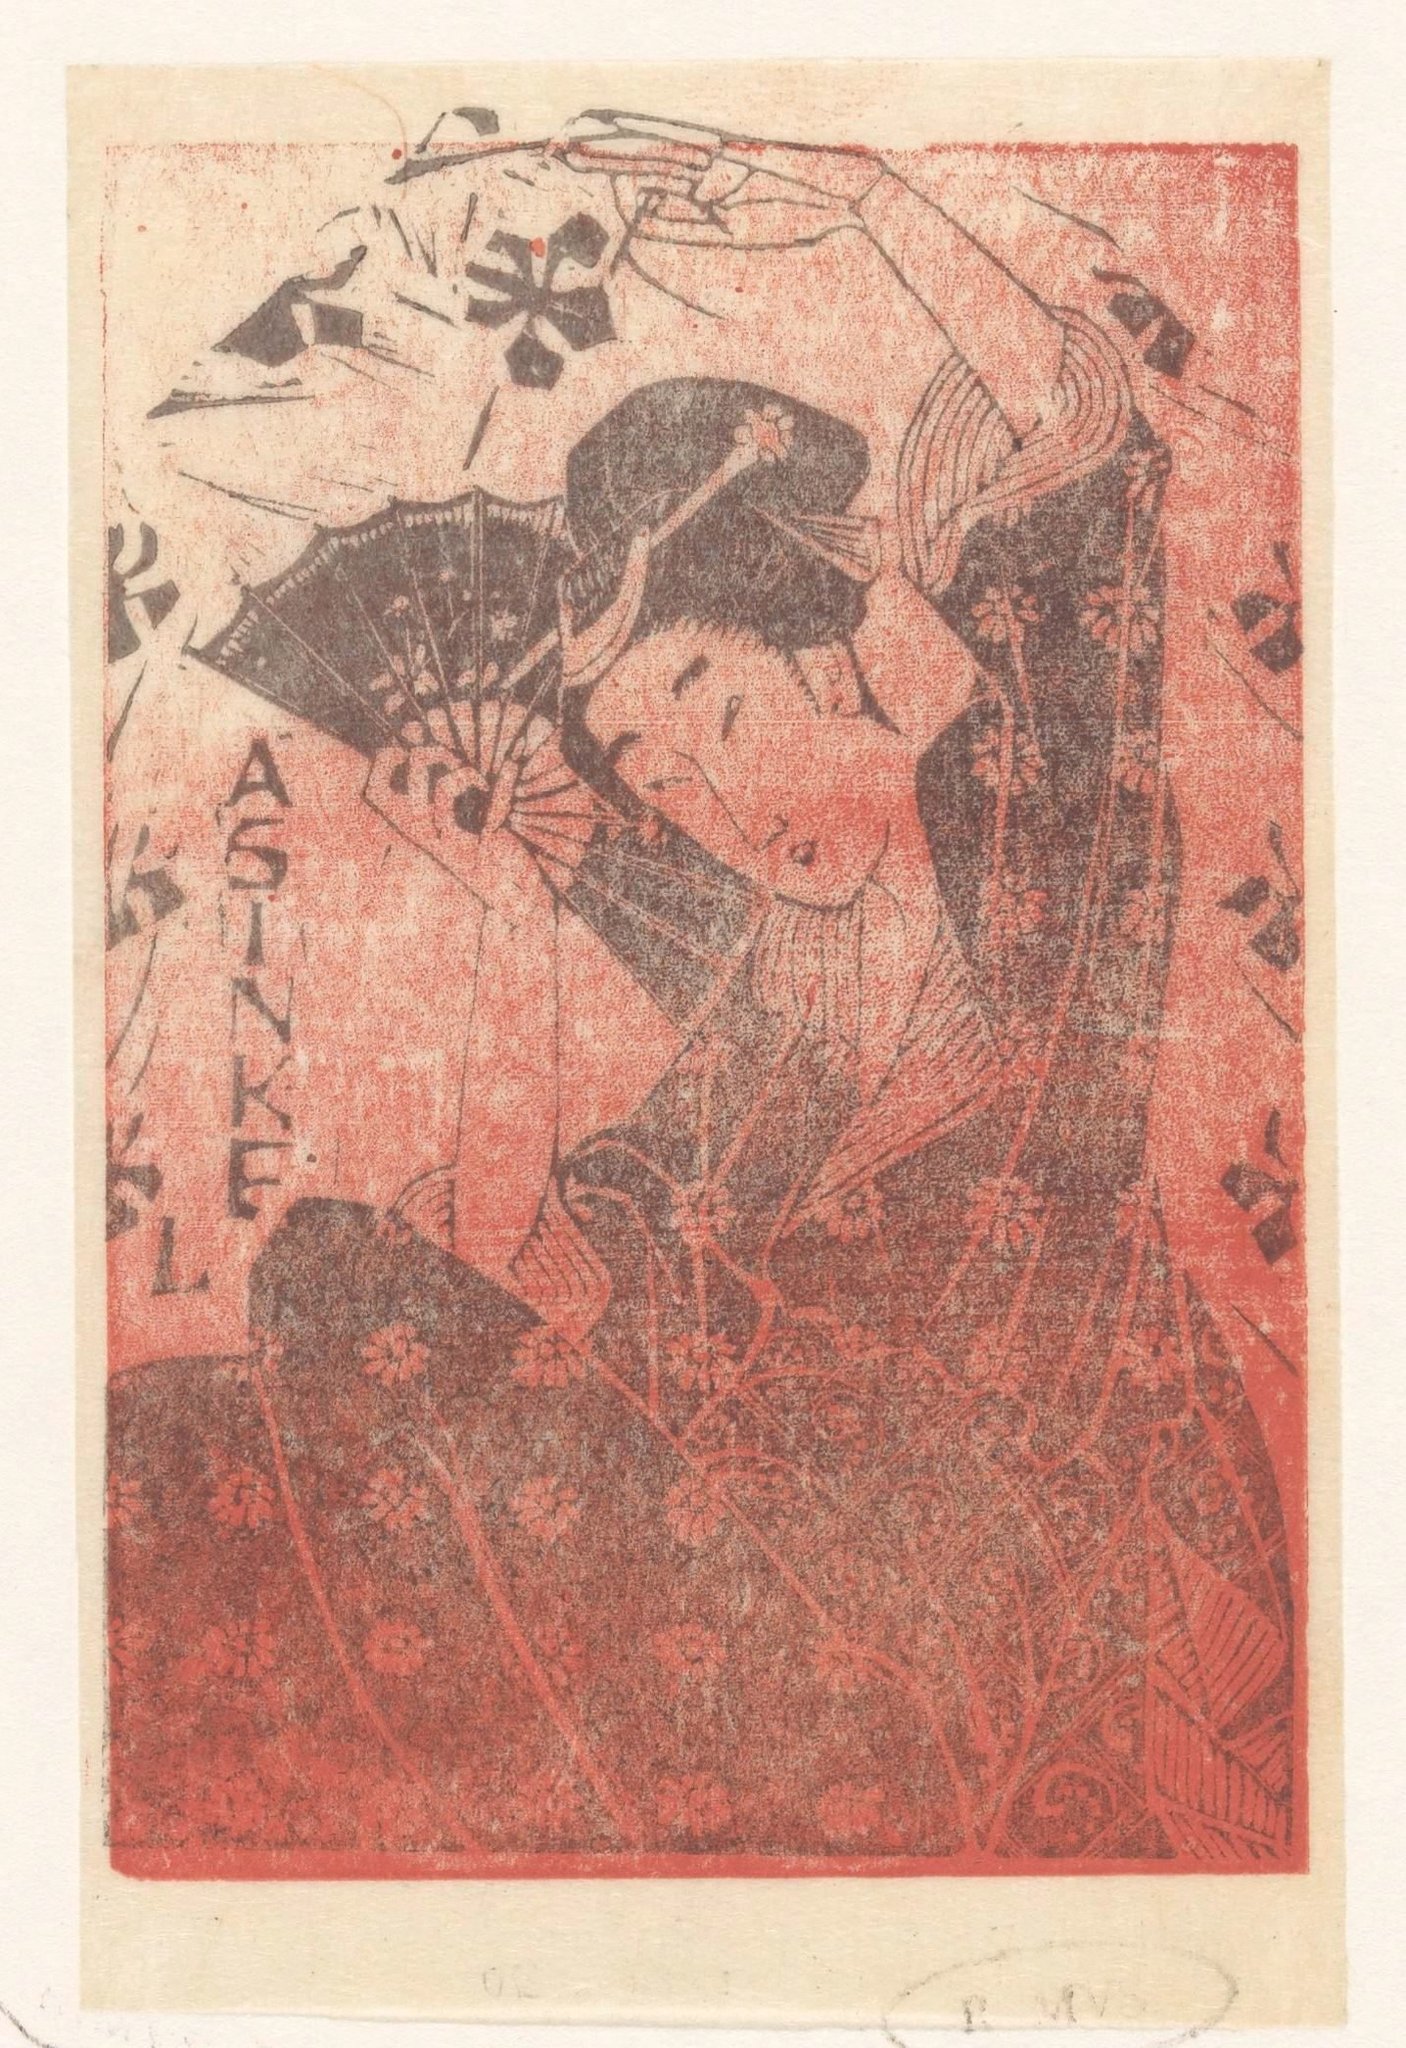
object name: print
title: Reclamekaart van A. Sinkel met Japanse vrouw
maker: mathieu lauweriks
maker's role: designer, draughtsman, print maker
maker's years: 1864-1932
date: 1874-1932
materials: paper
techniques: woodcut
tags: fan, japanese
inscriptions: collector's mark: Lugt 2228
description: Een Japanse vrouw met een waaier en haar arm boven haar hoofd. Links de tekst 'A Sinkel'.